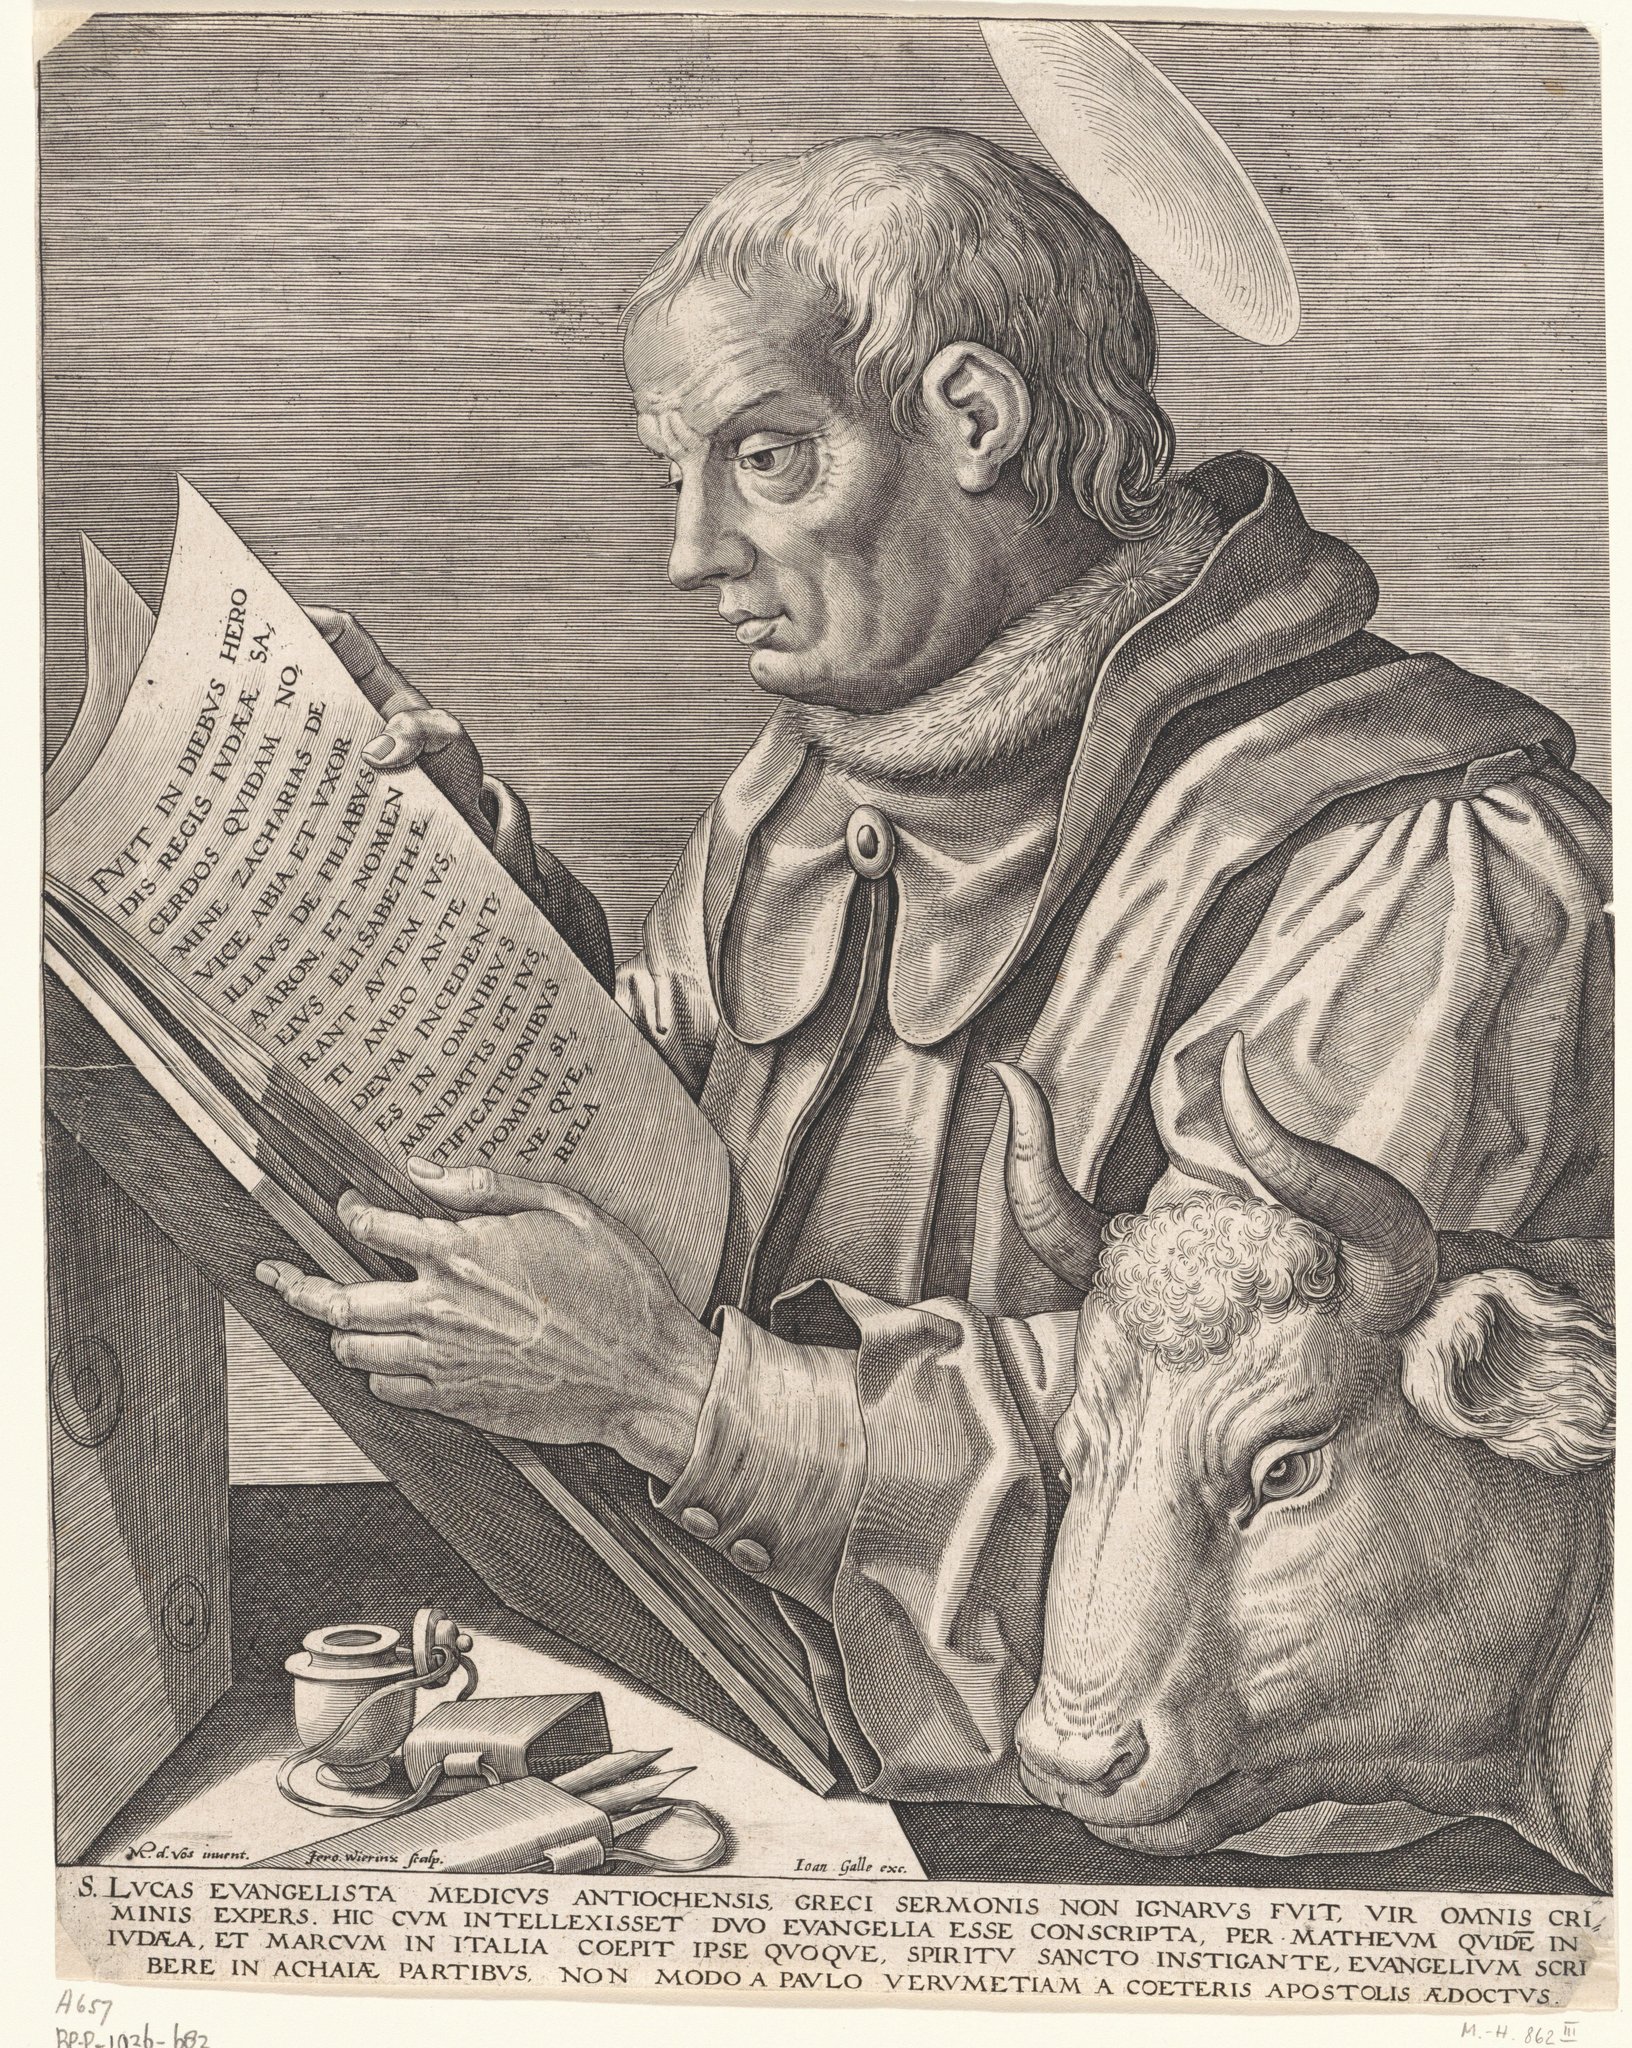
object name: print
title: Vier evangelisten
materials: paper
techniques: engraving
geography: antwerp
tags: luke the evangelist; possible attributes: book, (winged) ox, portrait of the virgin, surgical instruments, painter's utensils, scroll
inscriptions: collector's mark: Lugt 2166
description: De evangelist Lucas zit aan zijn schrijftafel en leest in zijn evangelie. Naast hem zijn attribuut de os. In de marge een vierregelig onderschrift in het Latijn.